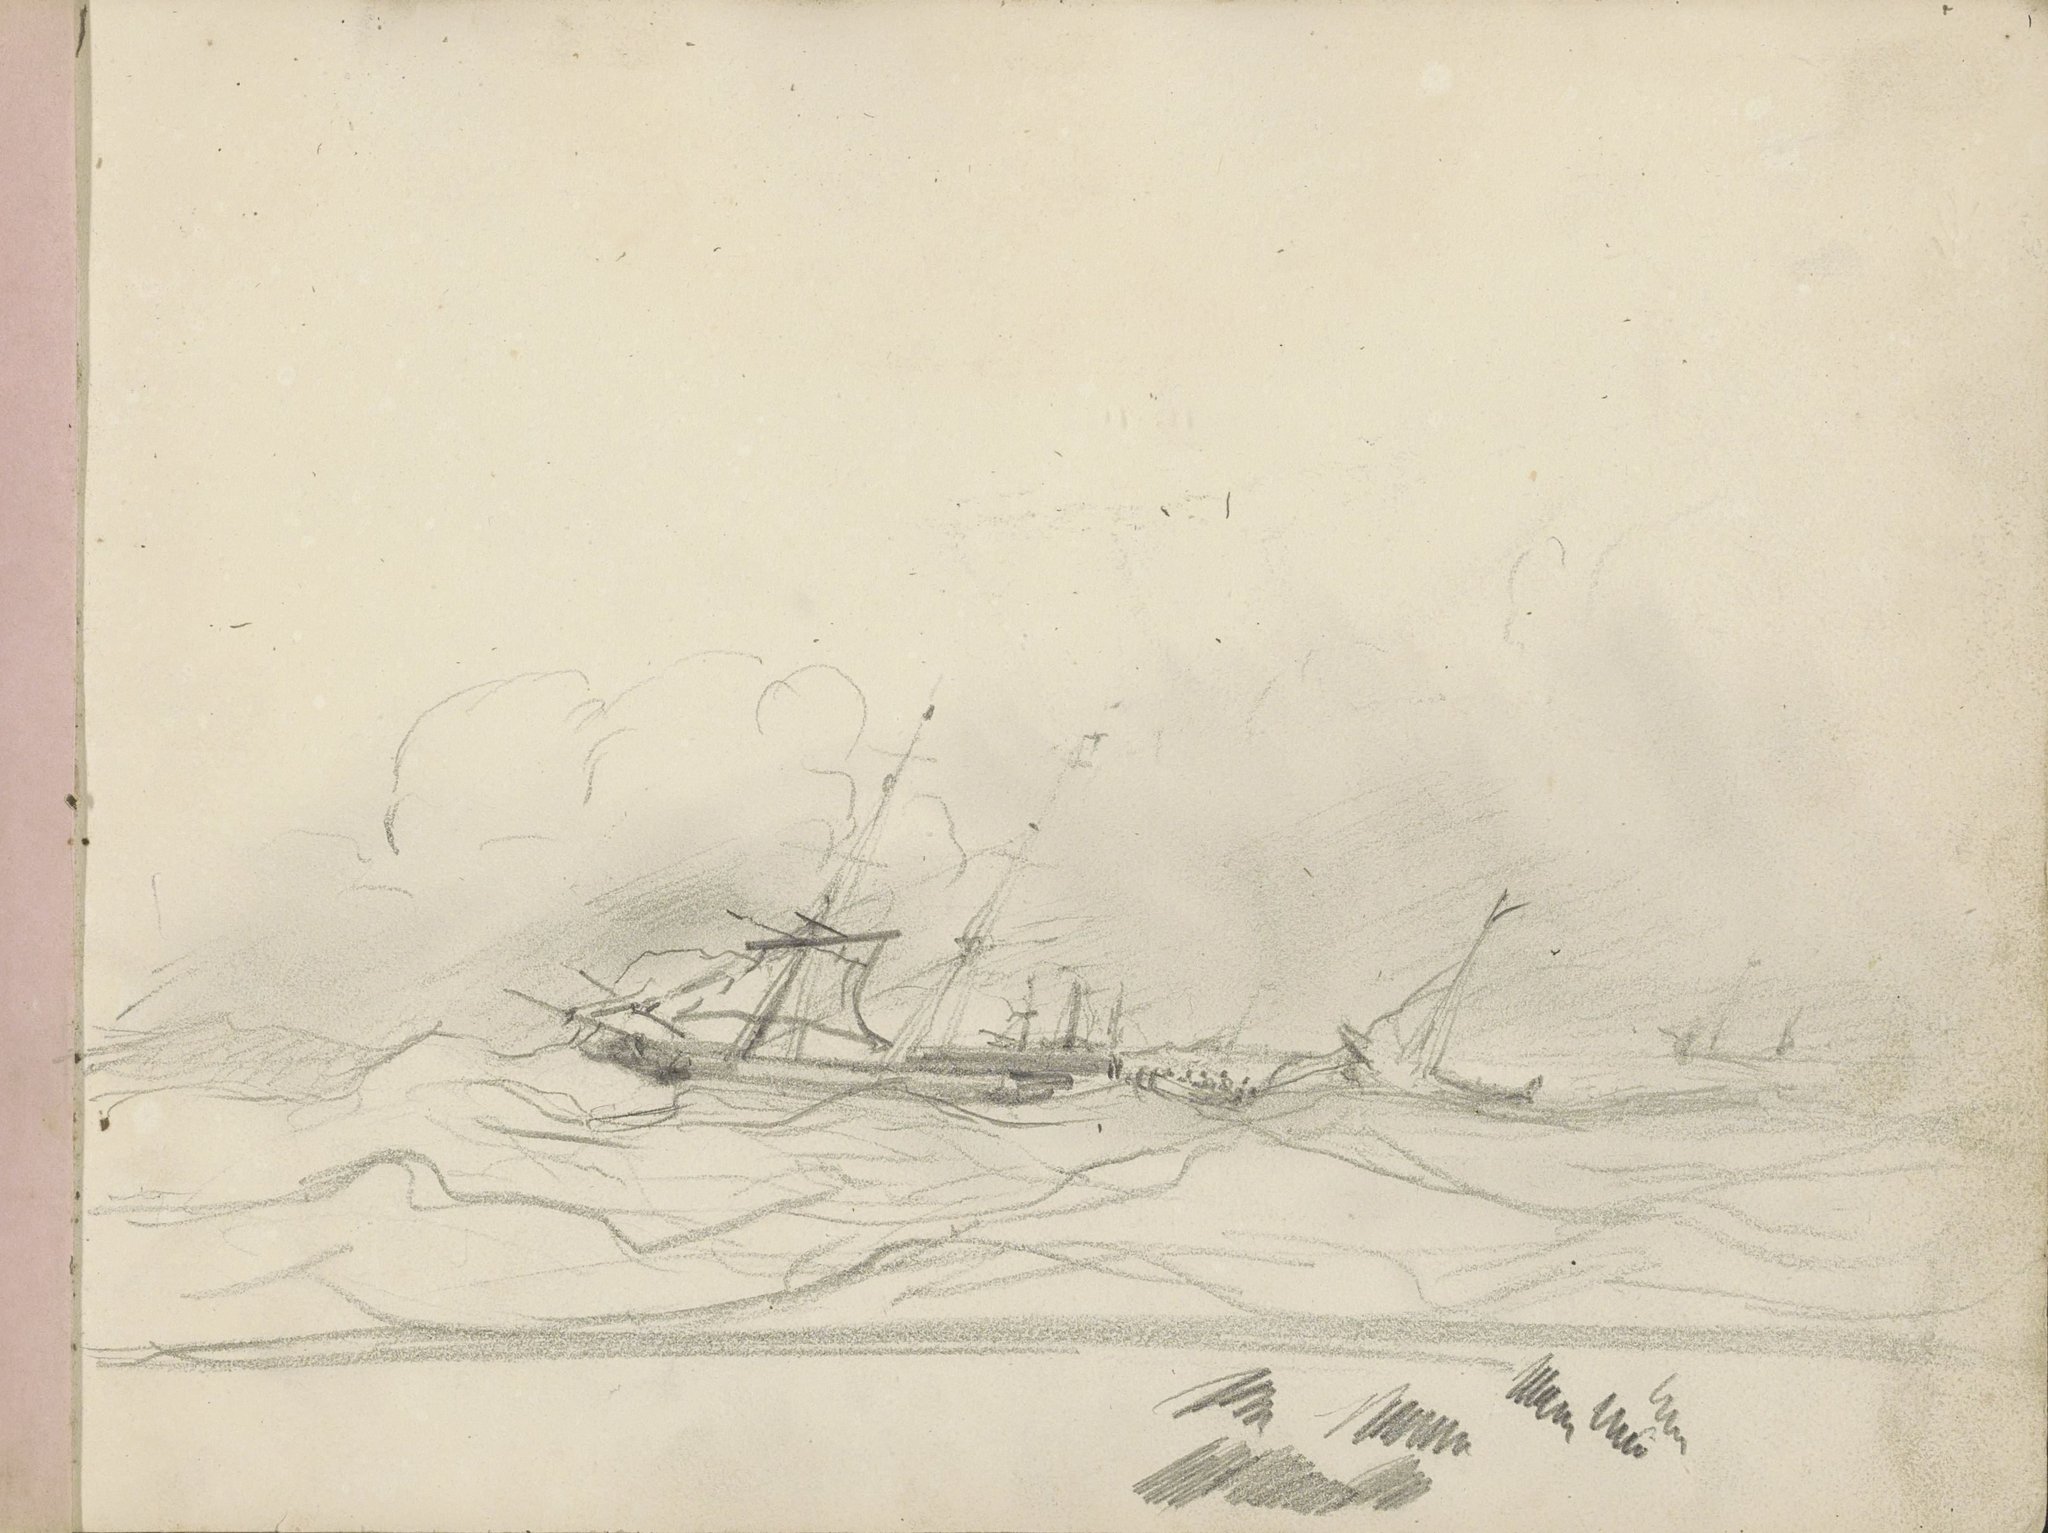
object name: sketchbook leaf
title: Zeilschepen op een woelige zee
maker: petrus johannes schotel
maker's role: draughtsman, painter, print maker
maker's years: 1808-1865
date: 1825-1875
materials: paper, pencil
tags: sailing-ship, sailing-boat, sea (seascape)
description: Blad 1 recto uit een schetsboek met 44 bladen.